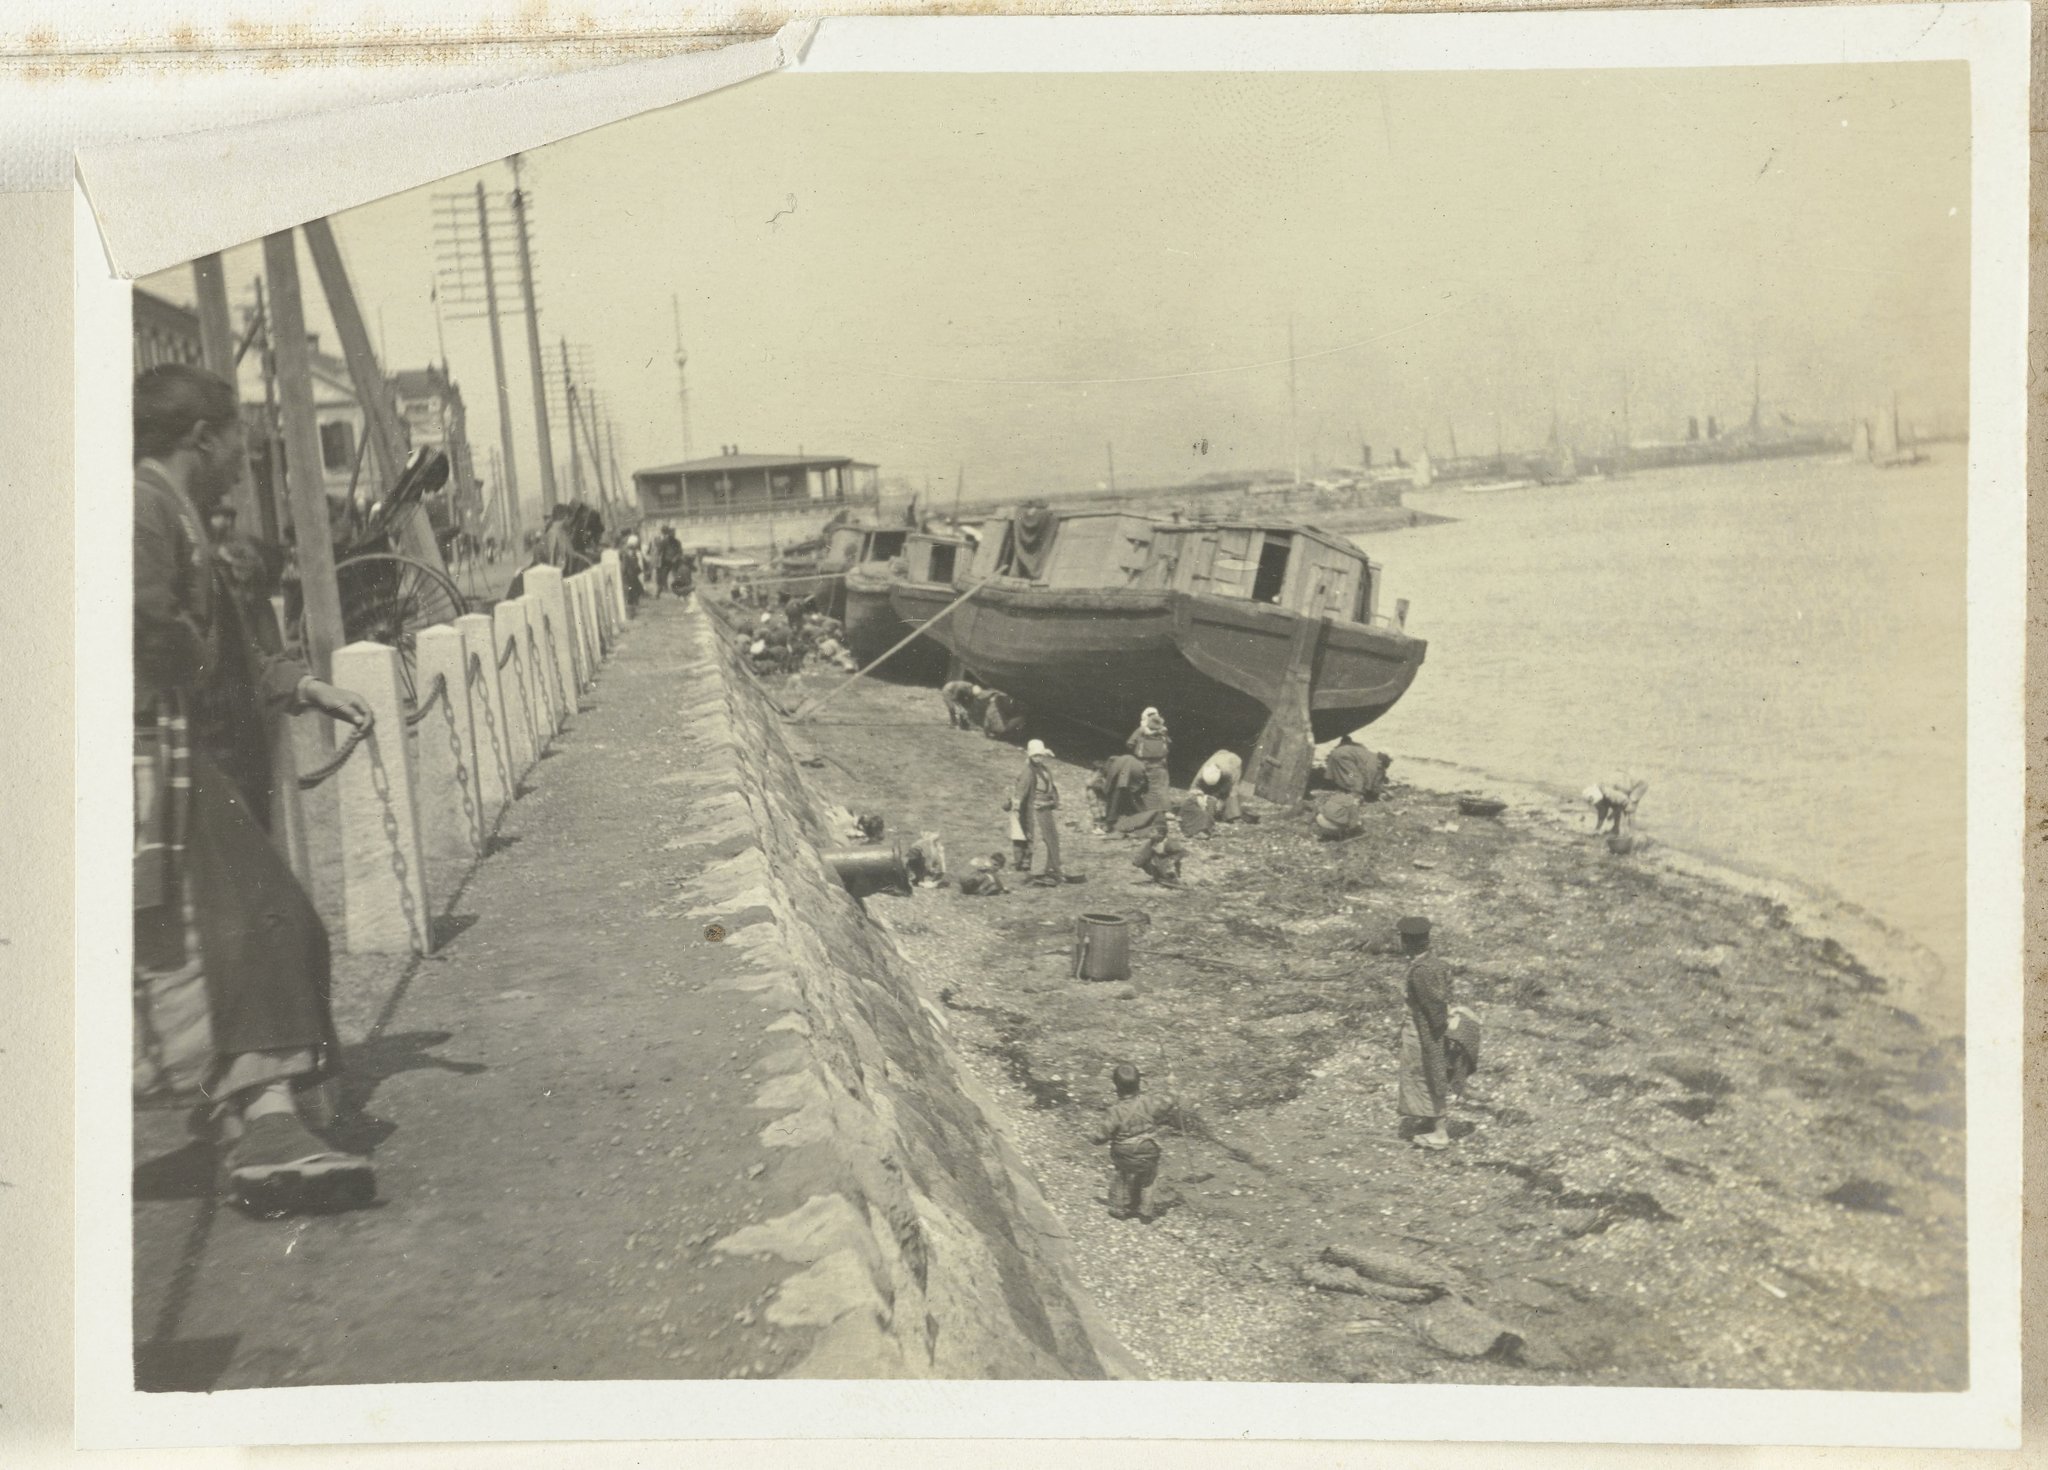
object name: photograph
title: Yokohama harbour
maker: geldolph adriaan kessler (dolph)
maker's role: fotograaf, industrieel, voetballer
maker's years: 1884-1945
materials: cardboard, photographic support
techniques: gelatin silver print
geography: yokohama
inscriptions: title: ‘Yokohama harbour’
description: Aan de kade in Yokohama, vrouwen zoeken schelpdieren. Onderdeel van het fotoalbum van Dolph Kessler met opnamen die hij maakte tijdens zijn verblijf in Engeland en op een wereldreis die hij als secretaris van Henri Deterding (directeur Koninklijke Olie) ondernam naar Nederlands-Indië, Japan, China en de Verenigde Staten, tussen 1906 en 1908.